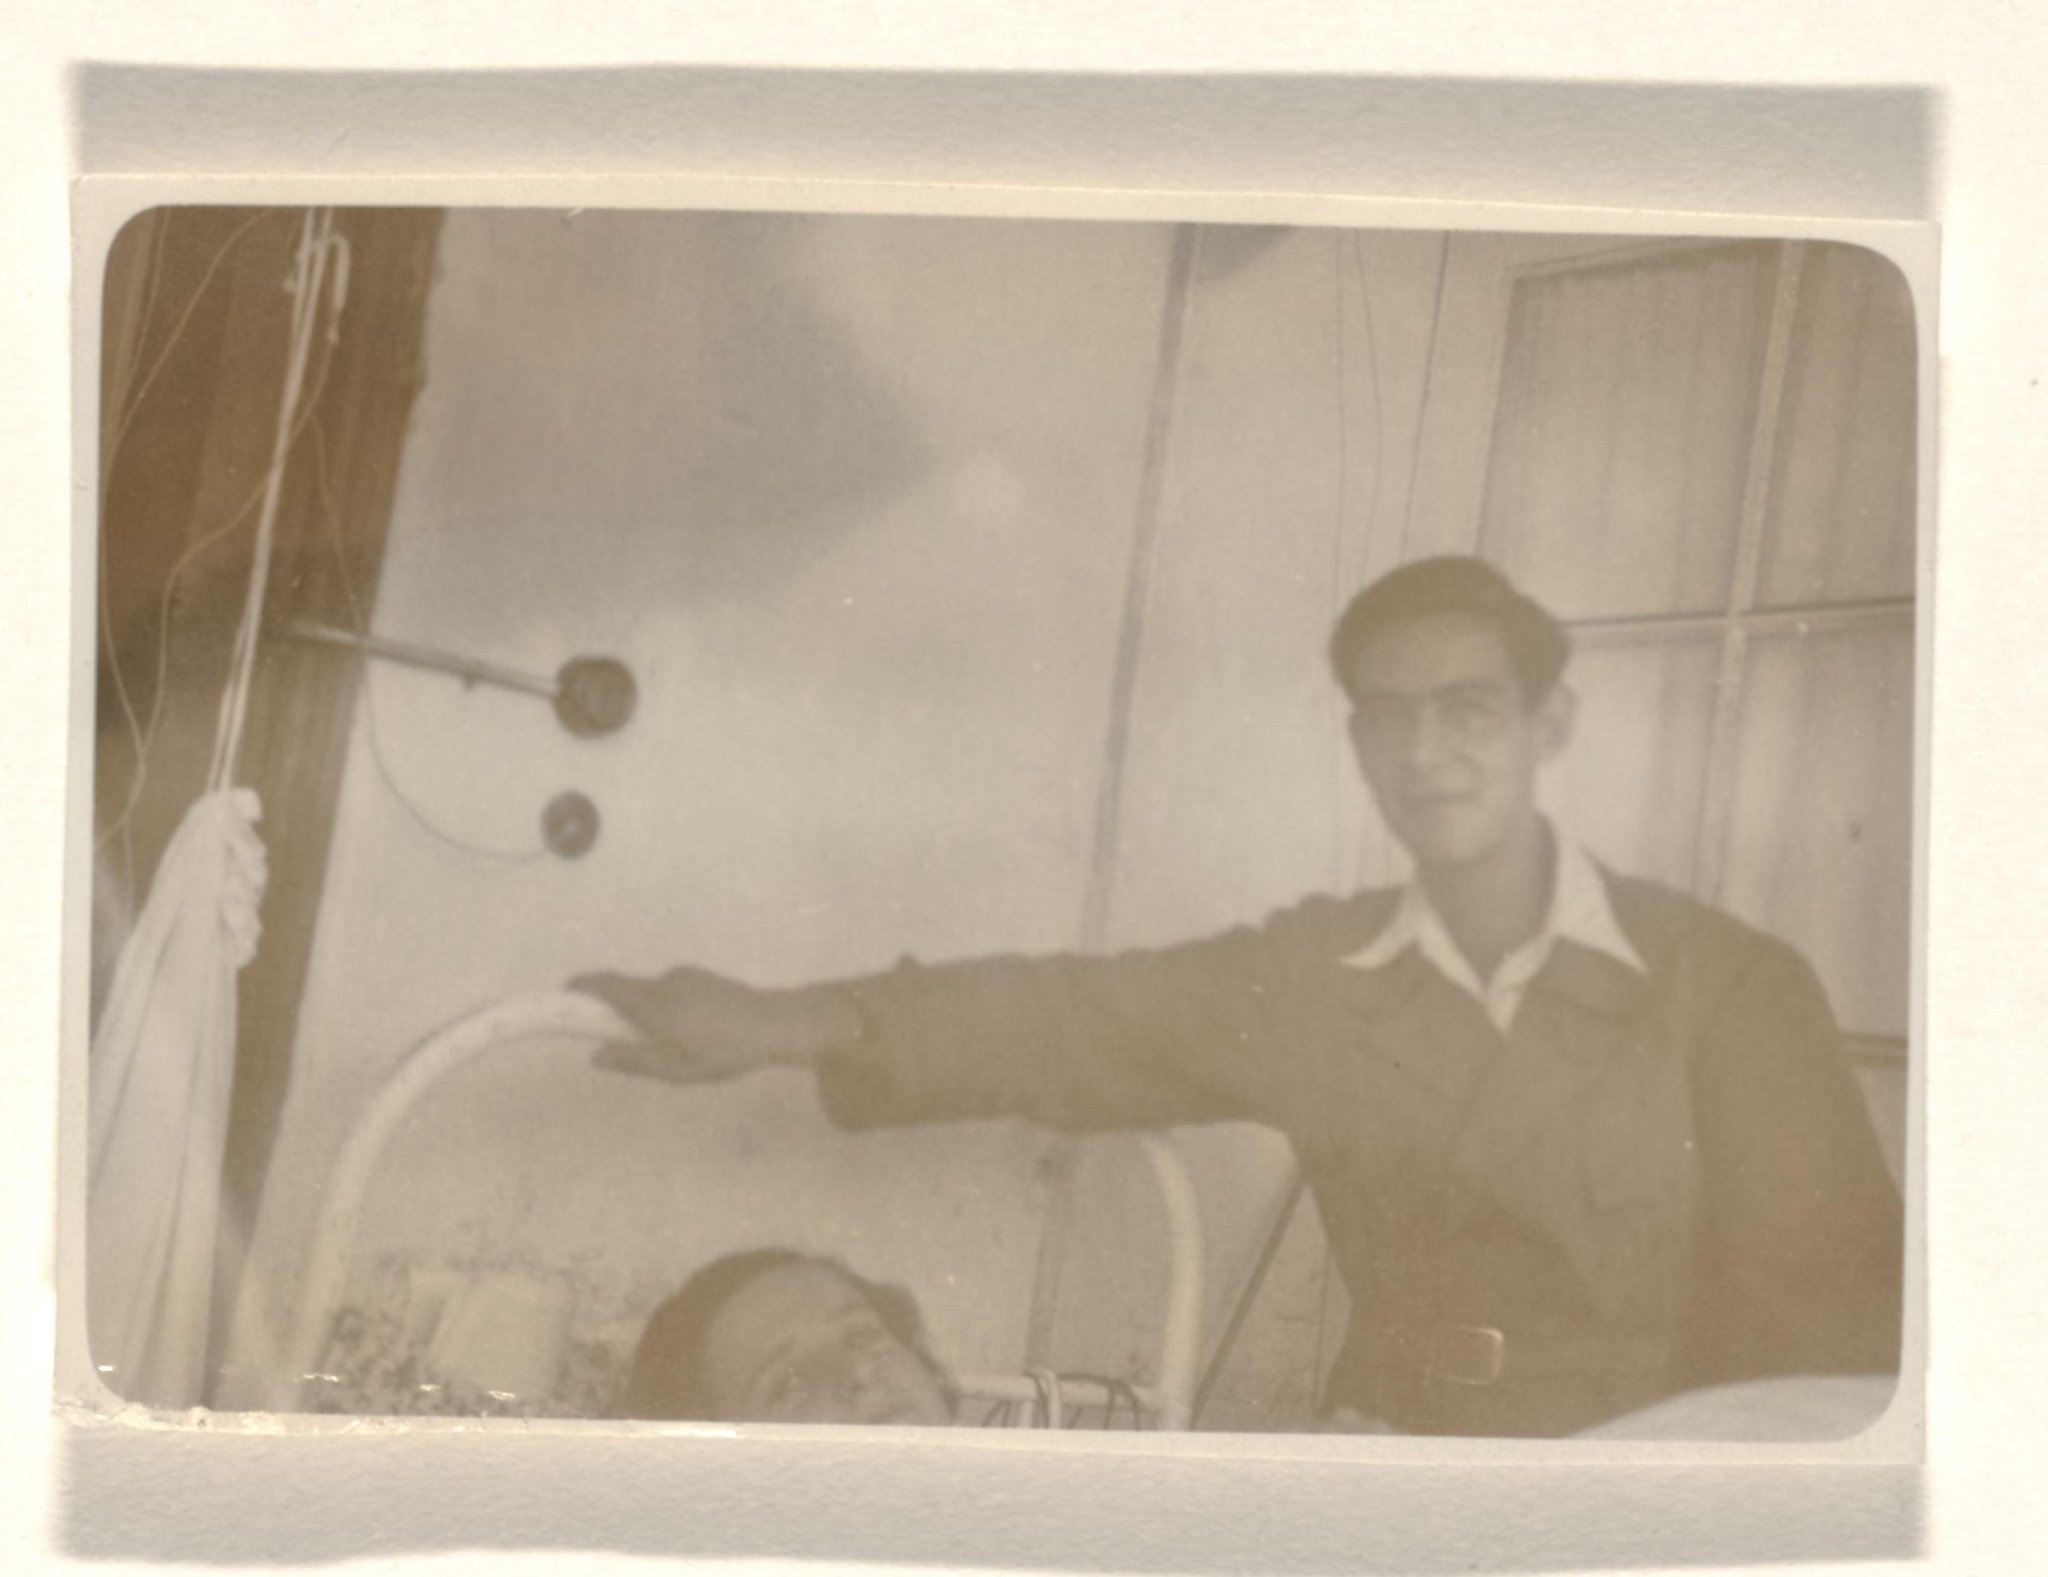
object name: photograph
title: Isabel Wachenheimer liggend in een ziekenhuisbed in het sanatorium Etania in Davos, met een onbekende man naast haar bed, 12 augustus 1945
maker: Anonymous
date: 1945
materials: photographic support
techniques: gelatin silver print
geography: davos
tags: leiden, isabel wachenheimer-elon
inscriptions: date: ‘Davos 12.8.1945.’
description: Isabel Wachenheimer liggend in een ziekenhuisbed in het sanatorium Etania in Davos, met een onbekende man naast haar bed.